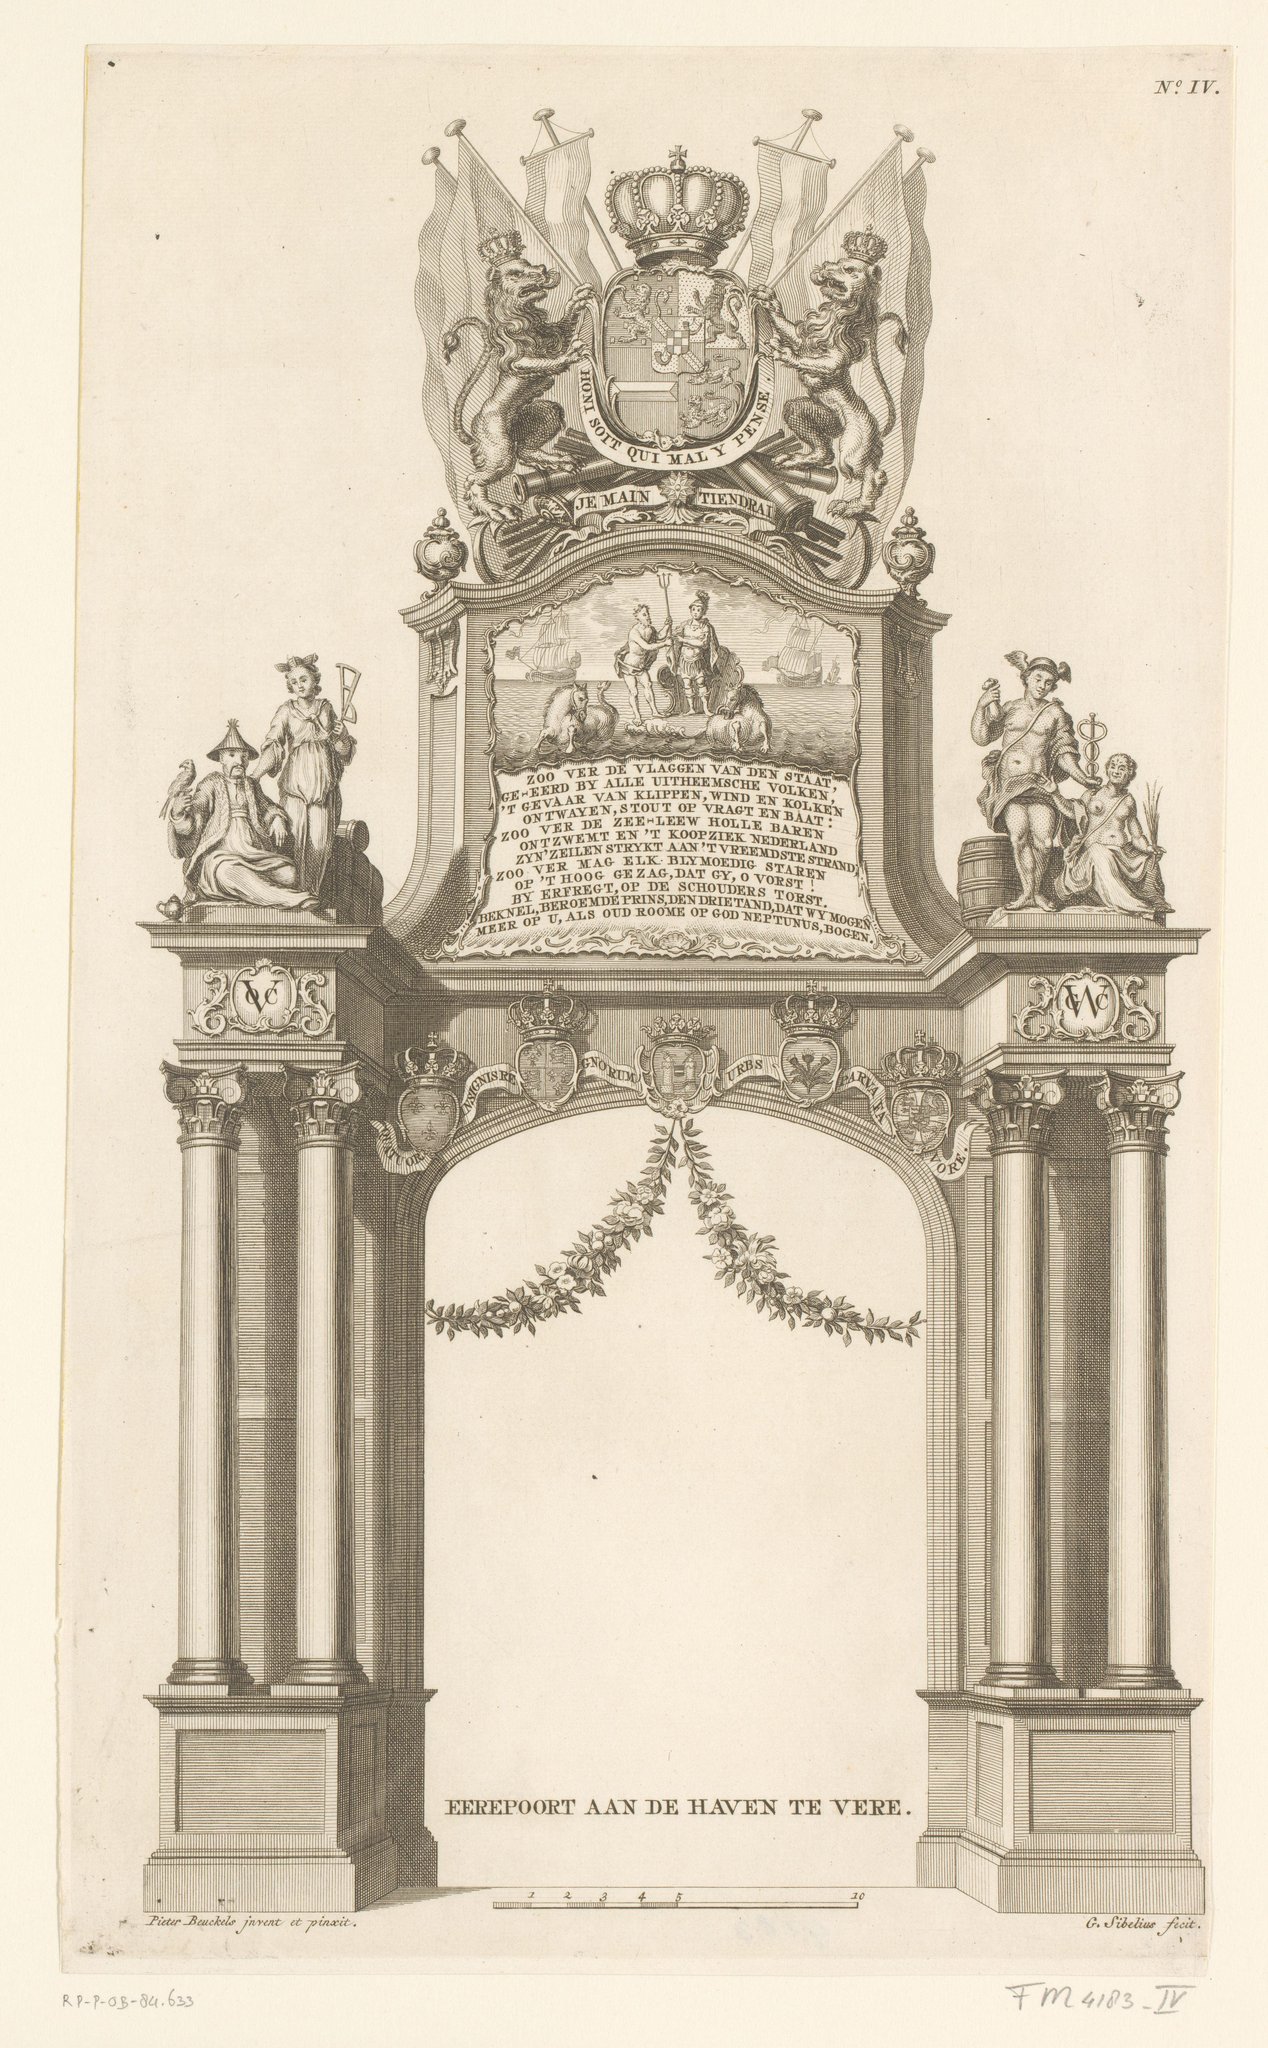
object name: print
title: Eerepoort aan de Haven te Vere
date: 1766-1767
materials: paper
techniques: engraving, etching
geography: northern netherlands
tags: the hague, william v (prince of orange), triumphal arch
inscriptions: collector's mark: Lugt 2228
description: De erepoort opgericht bij de haven te Veere. Bovenin monogrammen van de VOC en de WIC en een voorstelling van Willem V met Neptunus. Onderdeel van een groep van 10 platen van de decoraties te Veere ter gelegenheid van de inhuldiging van stadhouder Willem V als Markgraaf van Veere, 28 mei 1766. Genummerd rechtsboven: No. IV.